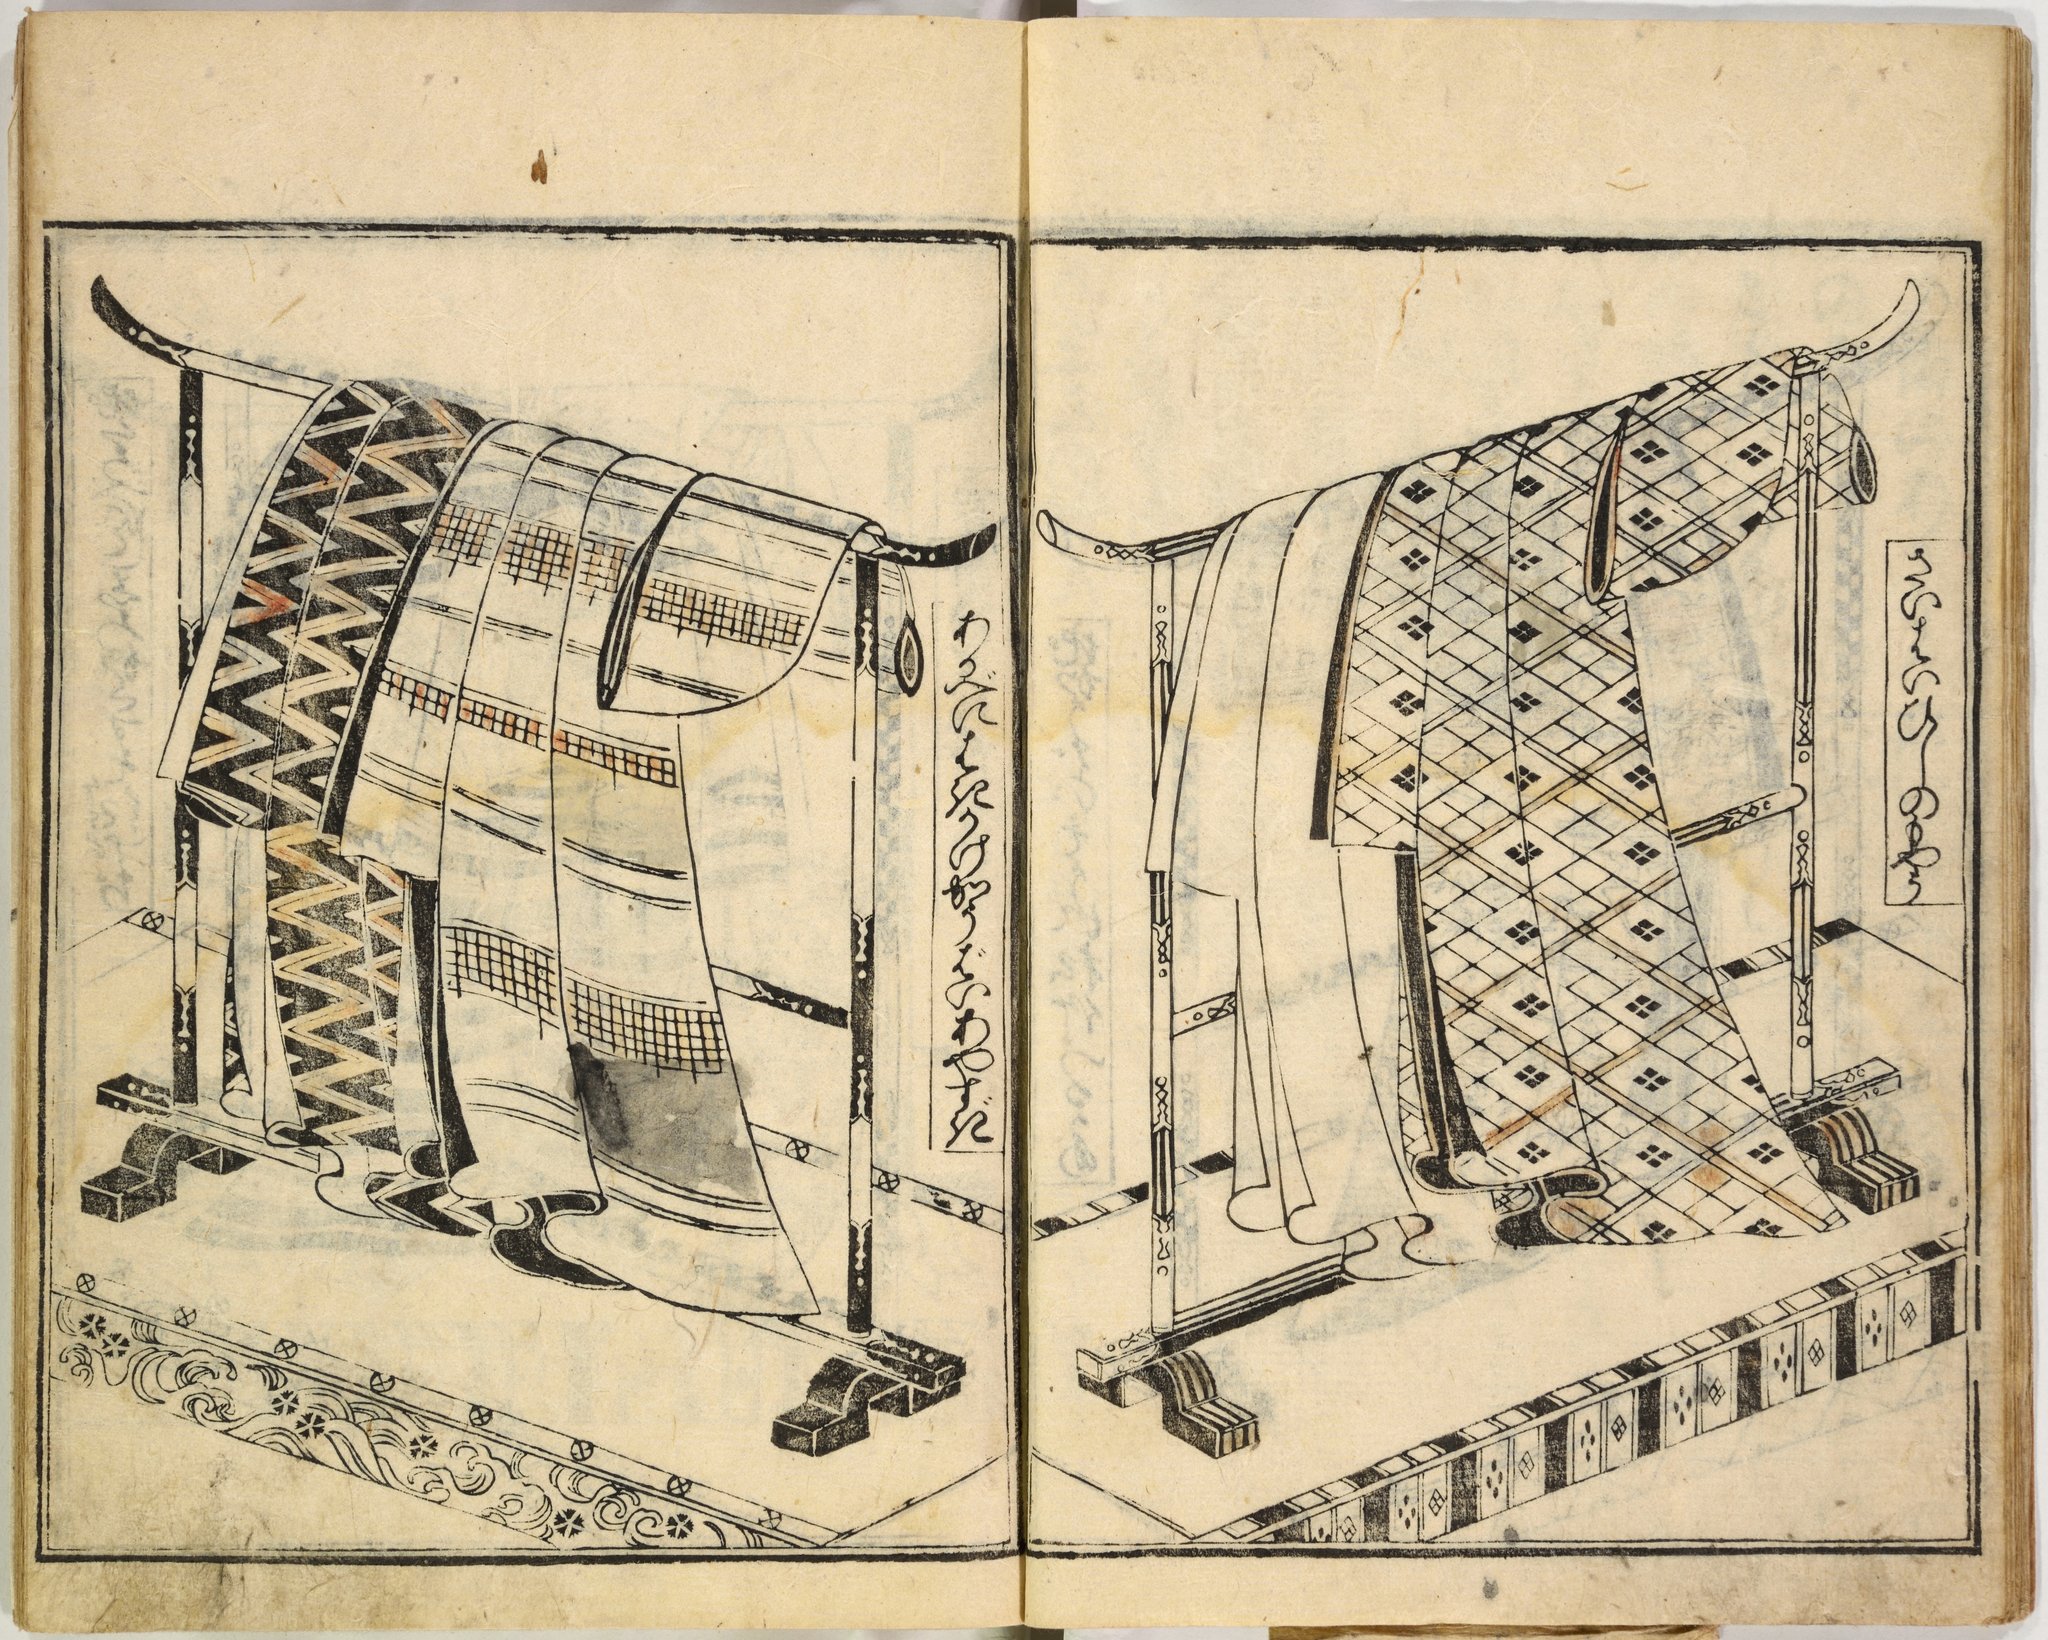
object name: illustrated book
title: Collection of Rules of Etiquette for Women (Onna shoreishū); 7 vols bound in 1 vol.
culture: japanese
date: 1660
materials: ink, paper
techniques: woodblock print